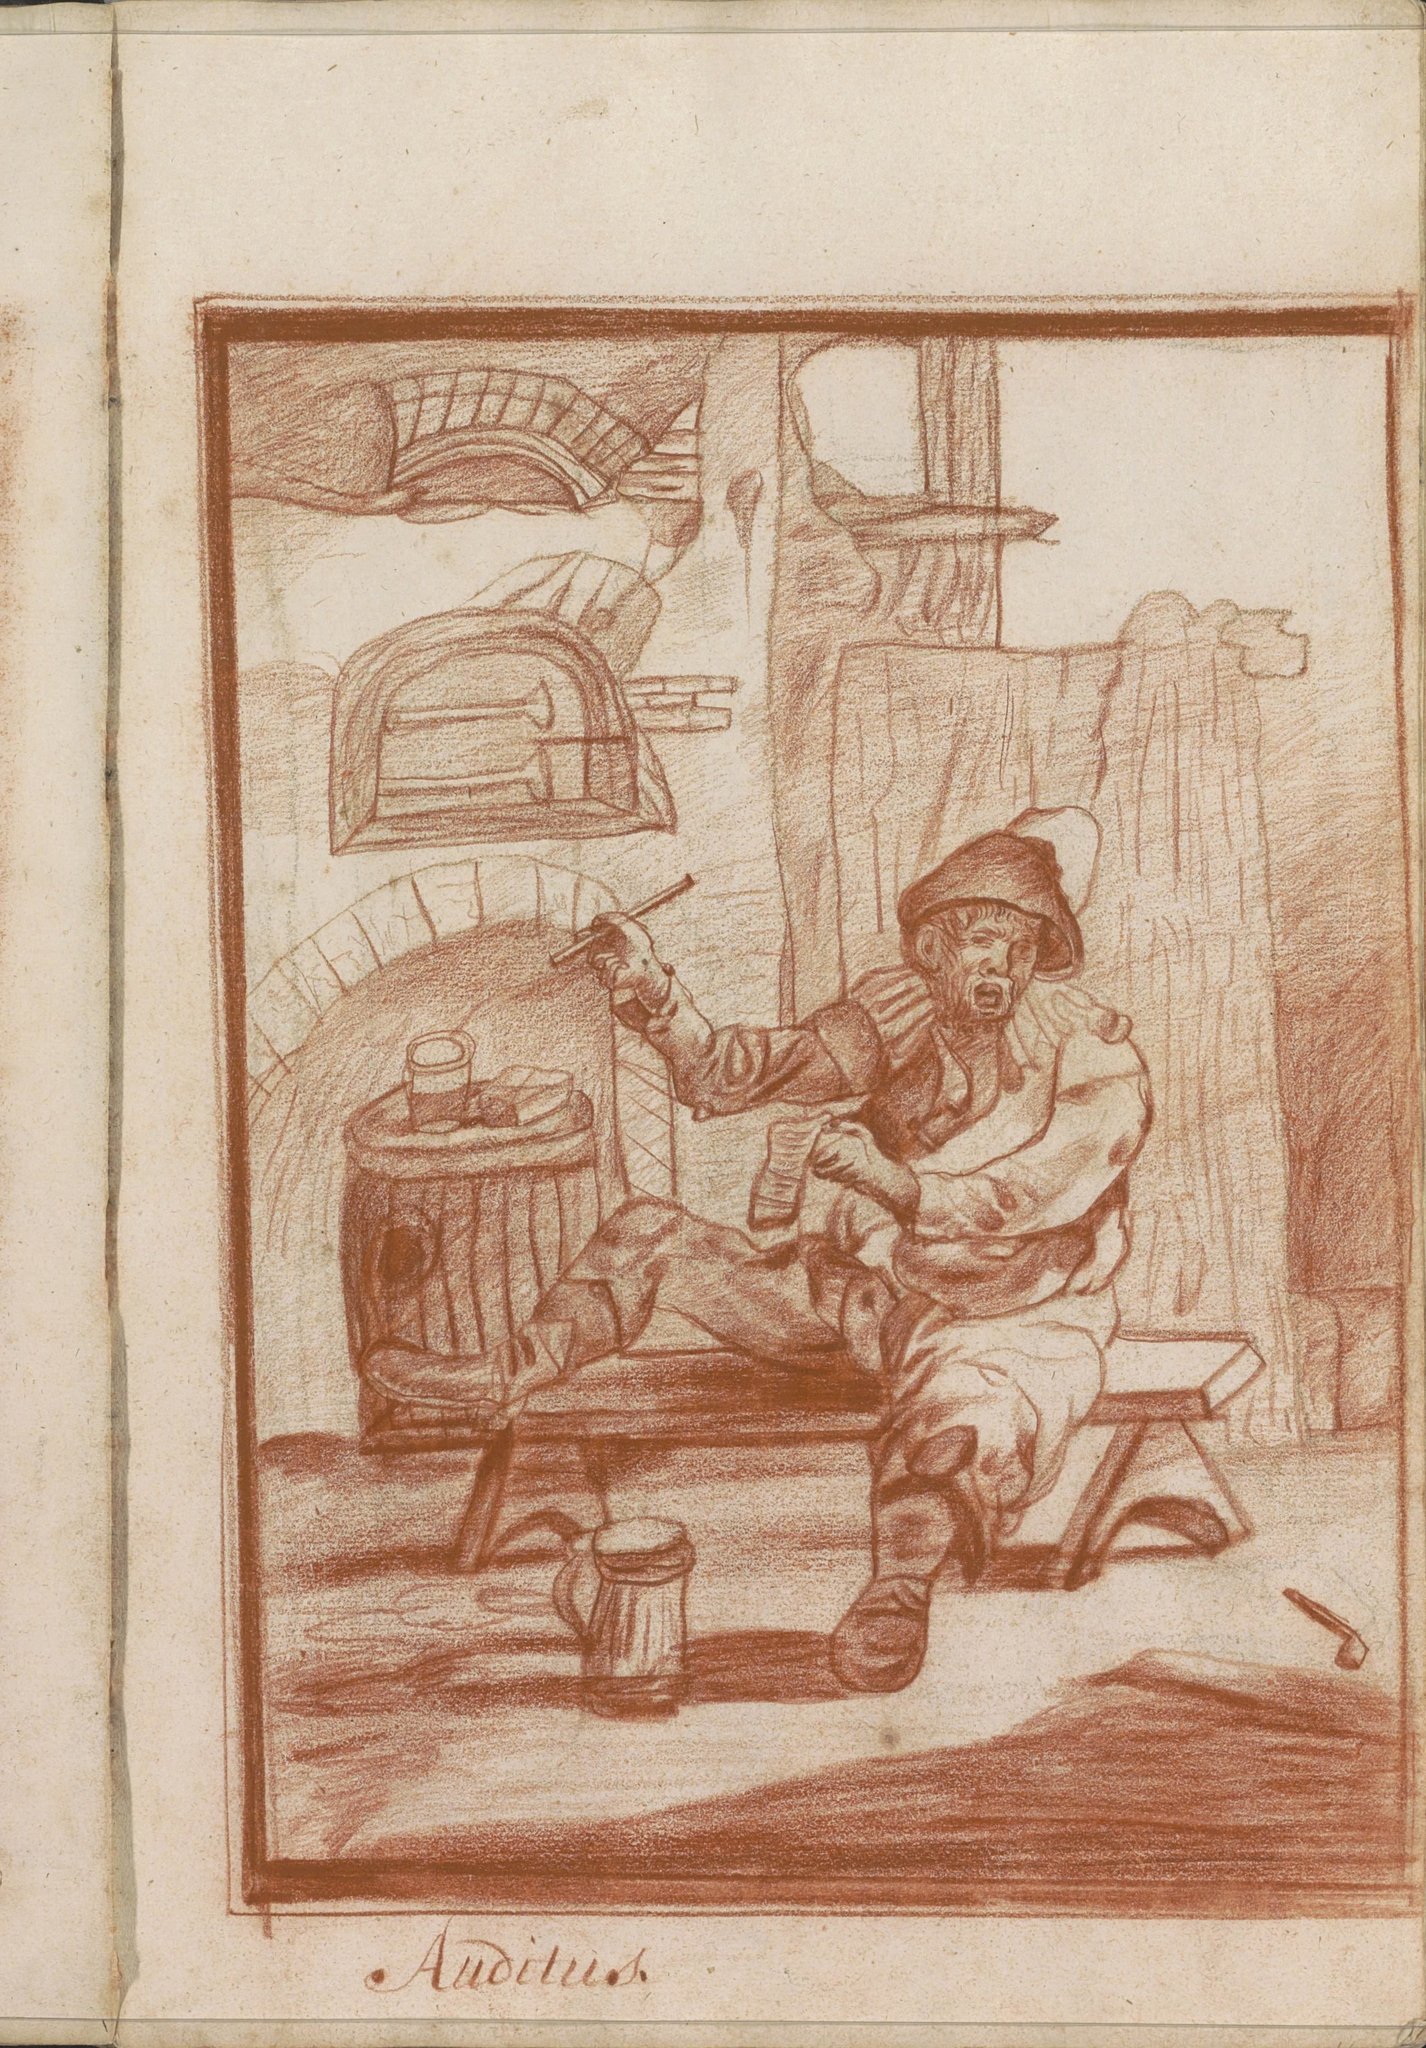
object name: sketchbook leaf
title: Gehoor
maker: hendrick van beaumont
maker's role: draughtsman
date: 1696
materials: chalk, paper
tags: hearing, listening (one of the five senses)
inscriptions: annotation: ‘Auditus’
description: Een man zit op een kruk voor een woning te zingen. Blad 15 recto uit een schetsboek met 91 bladen.